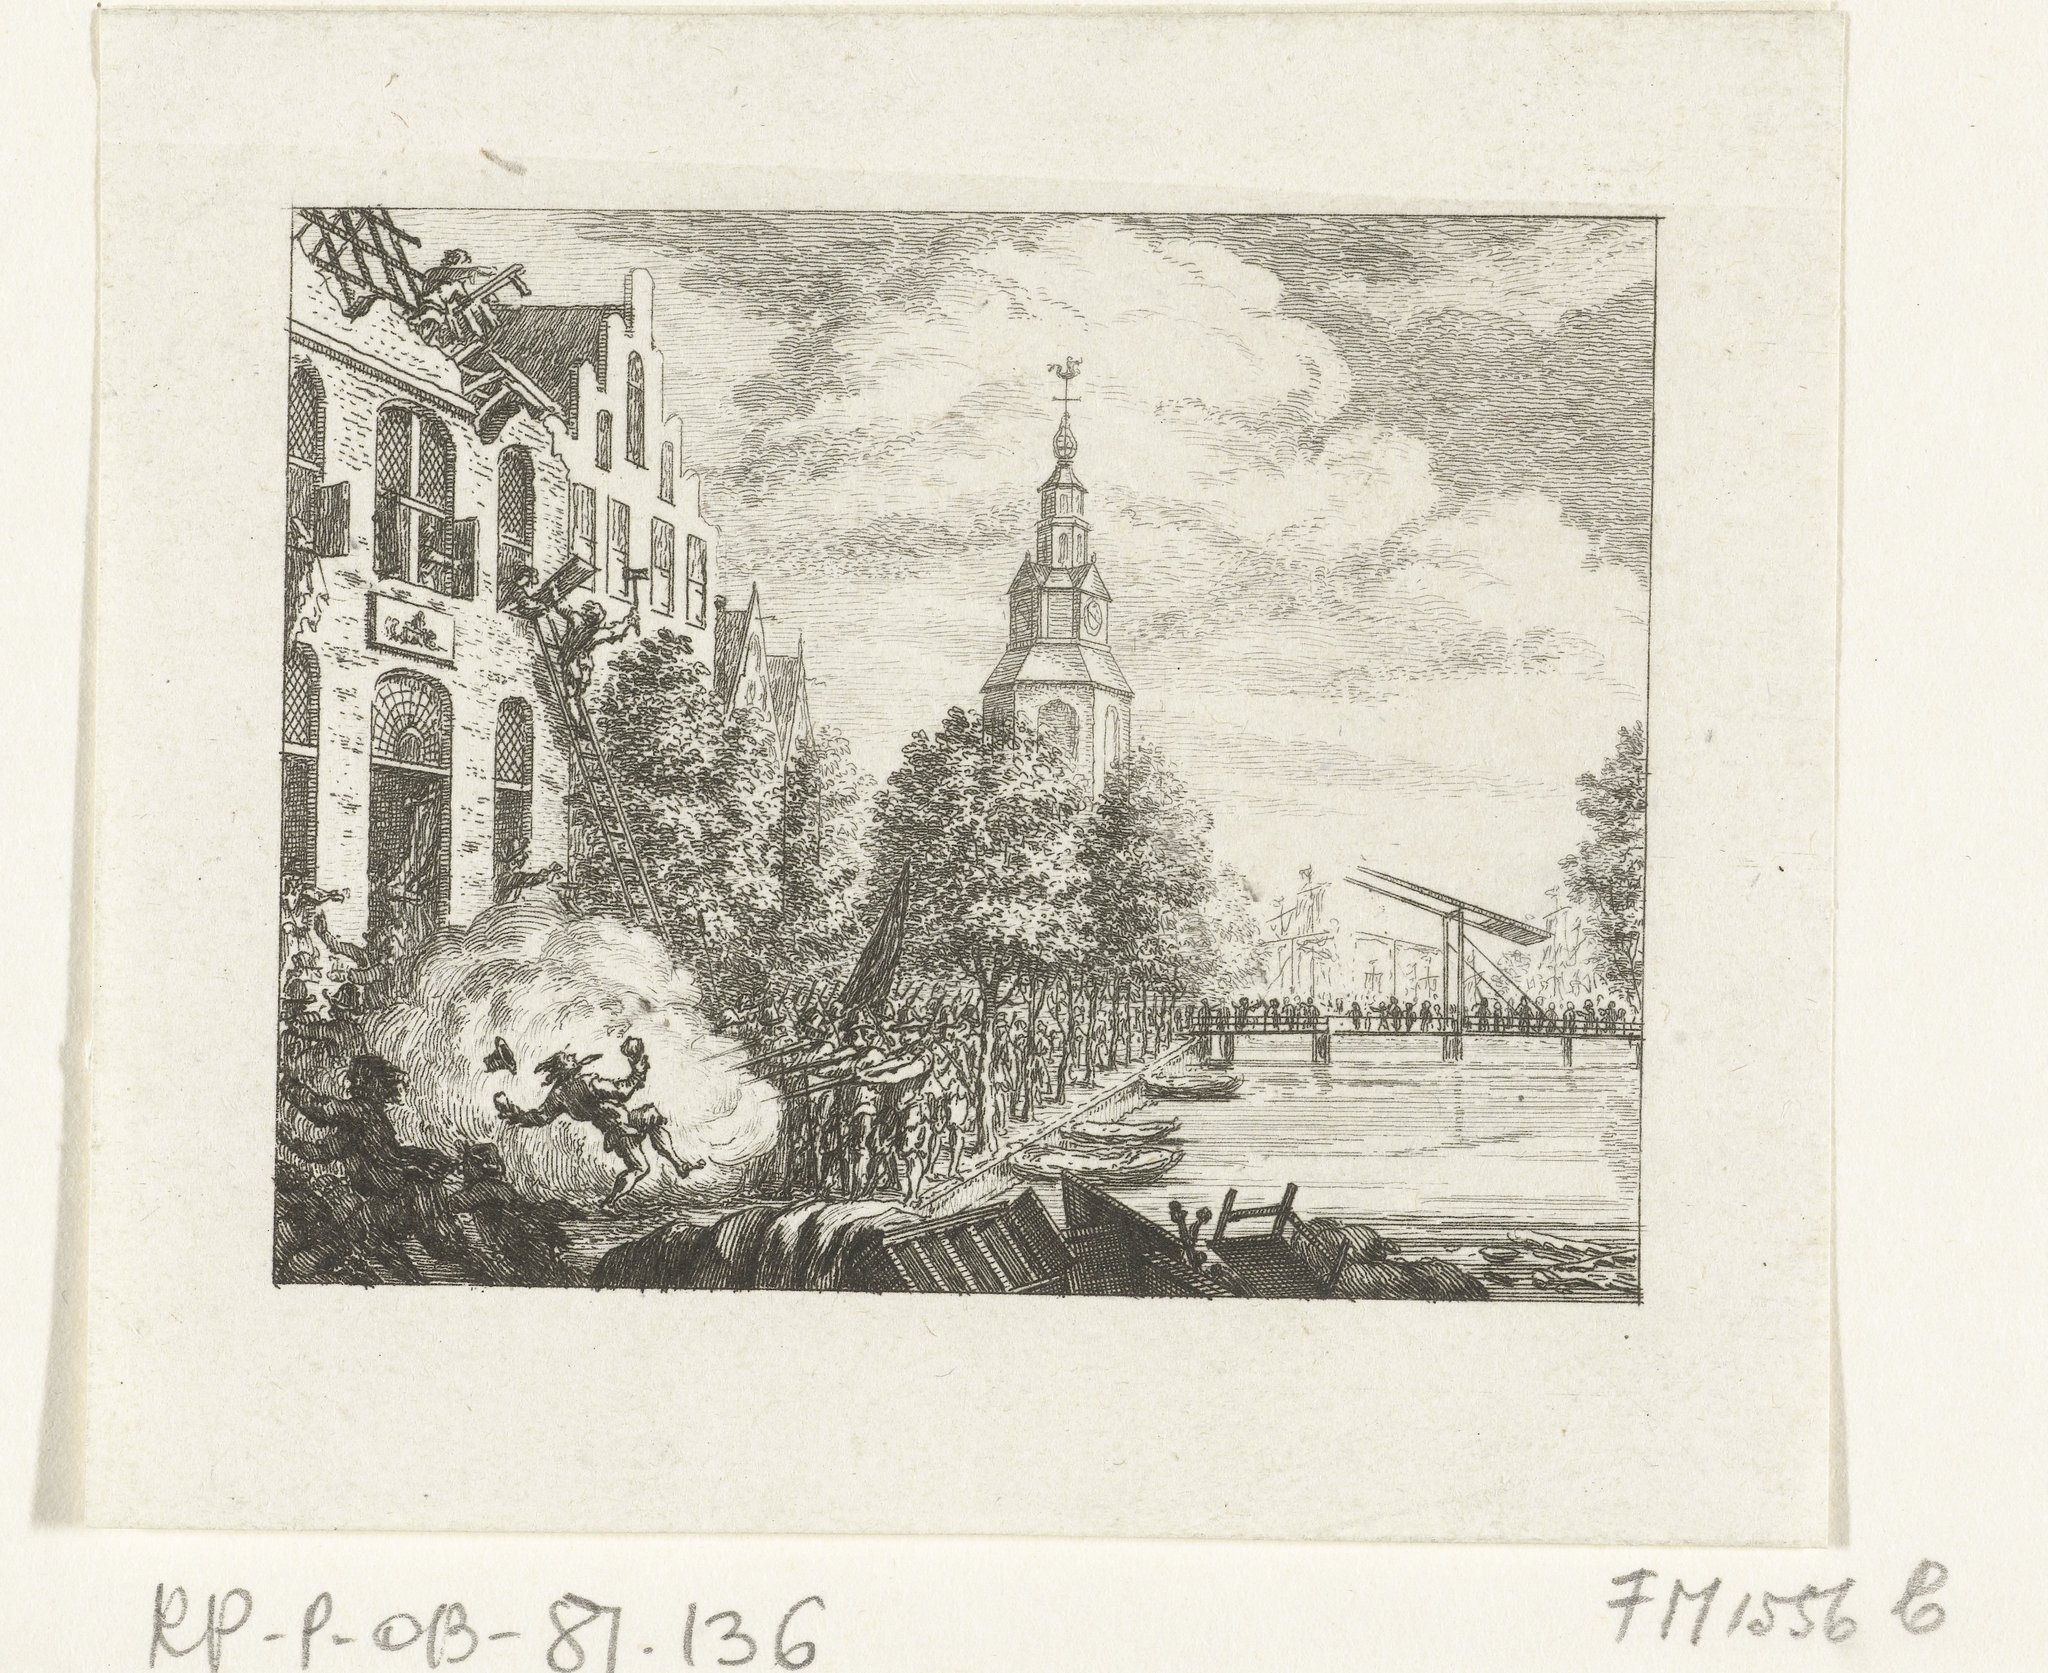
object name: history print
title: Plundering van een Remonstrantse kerk op de Oude Schans, 1626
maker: simon fokke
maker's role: draughtsman, print maker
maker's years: 1712-1784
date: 1779-1781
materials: paper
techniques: etching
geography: northern netherlands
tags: plundering ~ riot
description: Volgens de catalogus van de Atlas van Stolk onderdeel van een serie van 7 prentjes van straatoproer te Amsterdam, in 1781 verschenen.